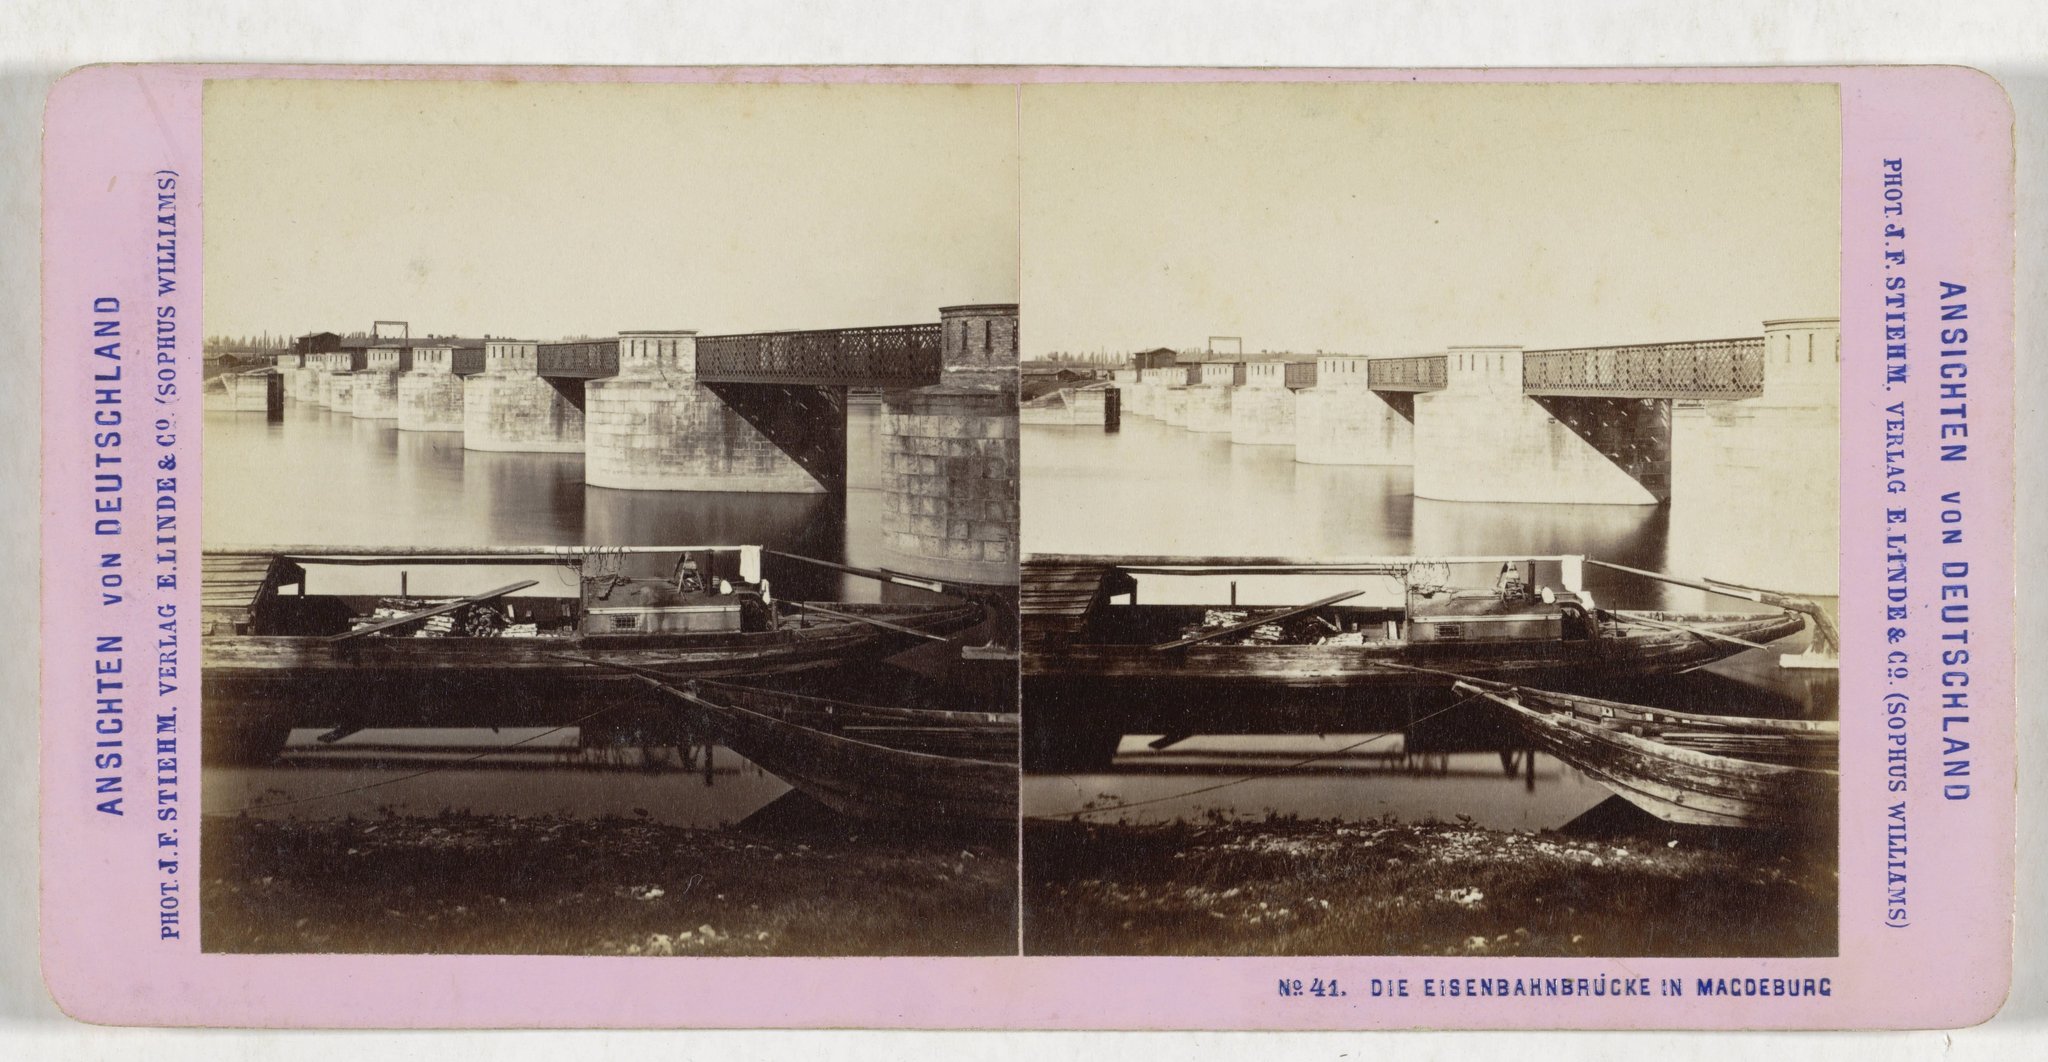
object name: stereograph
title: Ansichten von Deutschland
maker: johann friedrich stiehm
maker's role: fotograaf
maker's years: 1826-1902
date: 1869-1872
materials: cardboard, paper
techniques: albumen print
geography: magdeburg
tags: bridge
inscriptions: number: ‘No 41.’